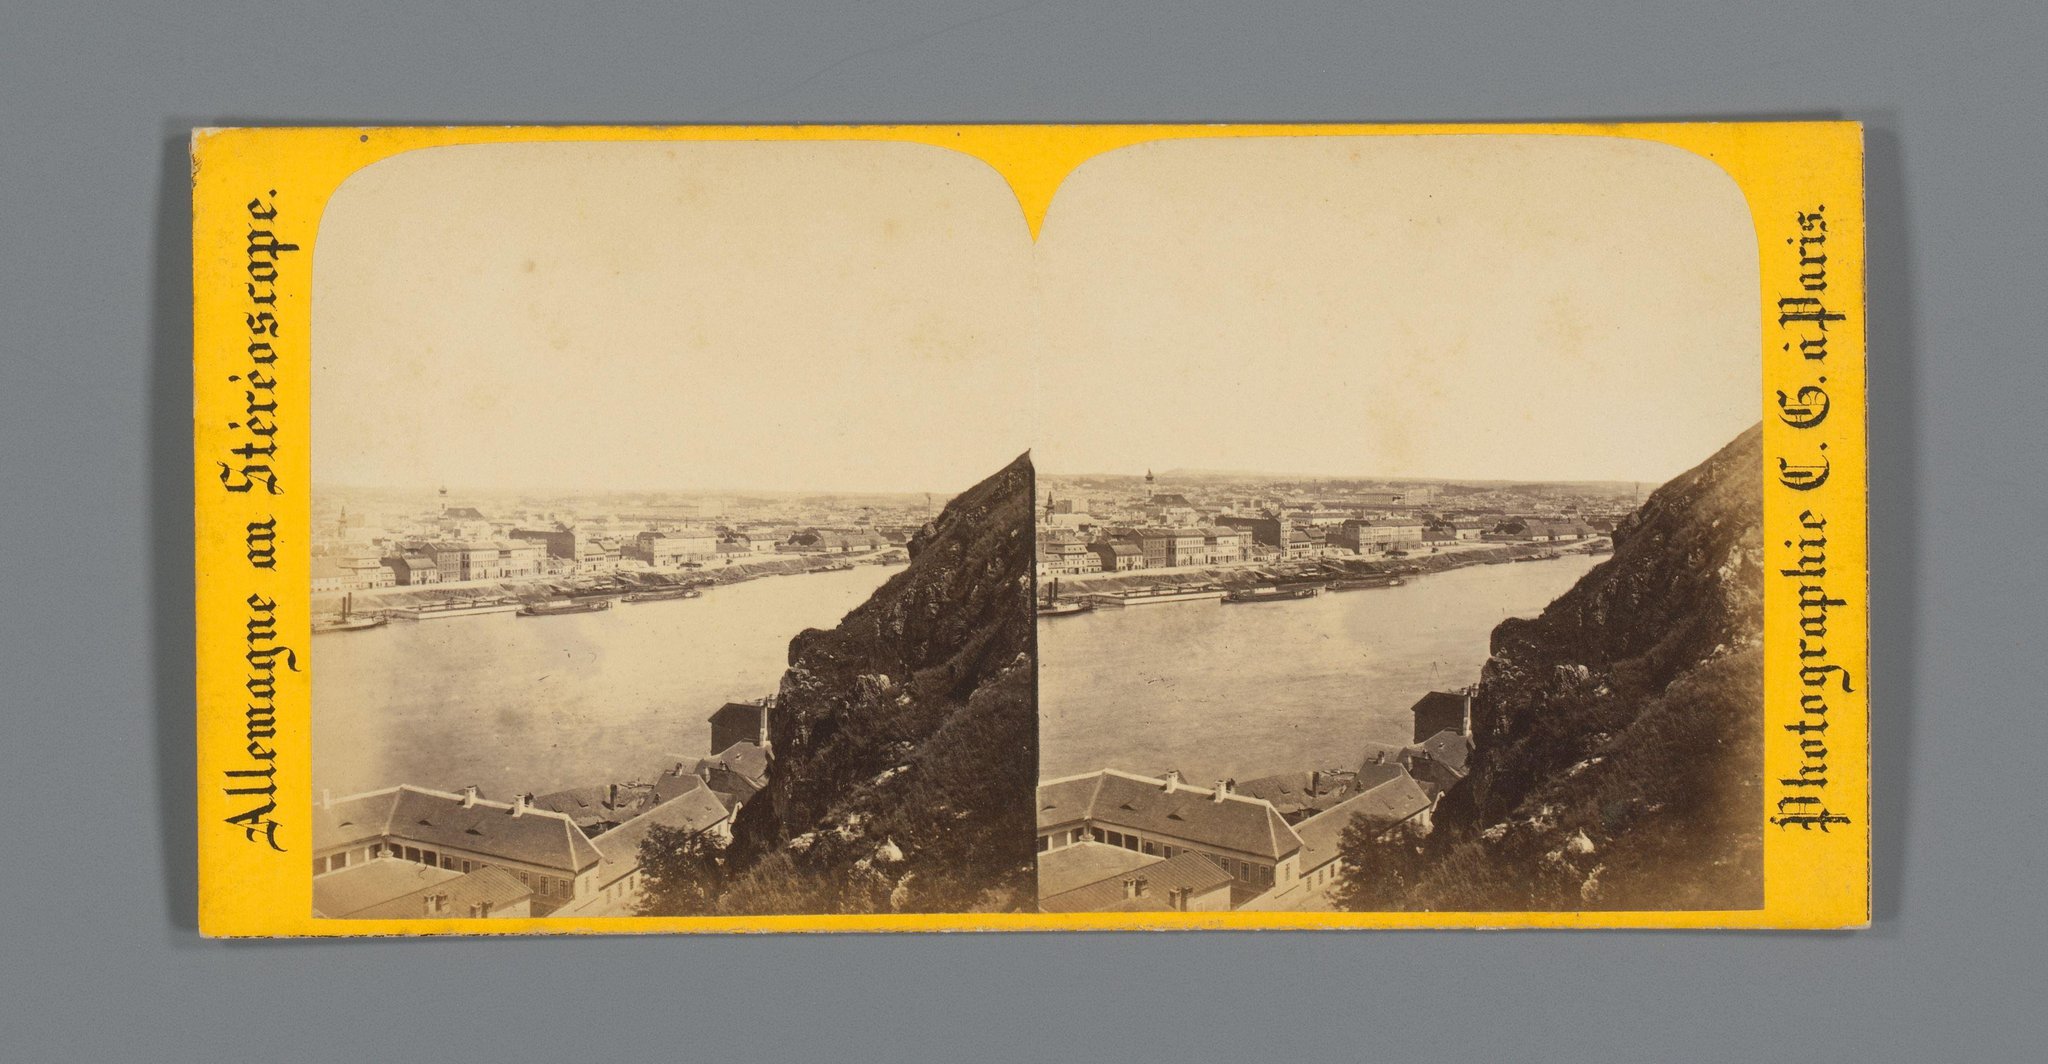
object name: stereograph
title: Allemagne au stéréoscope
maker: charles gaudin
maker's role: publisher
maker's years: 1825-1905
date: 1868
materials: cardboard, paper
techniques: albumen print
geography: budapest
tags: city-view in general; 'veduta'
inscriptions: number: ‘134.’